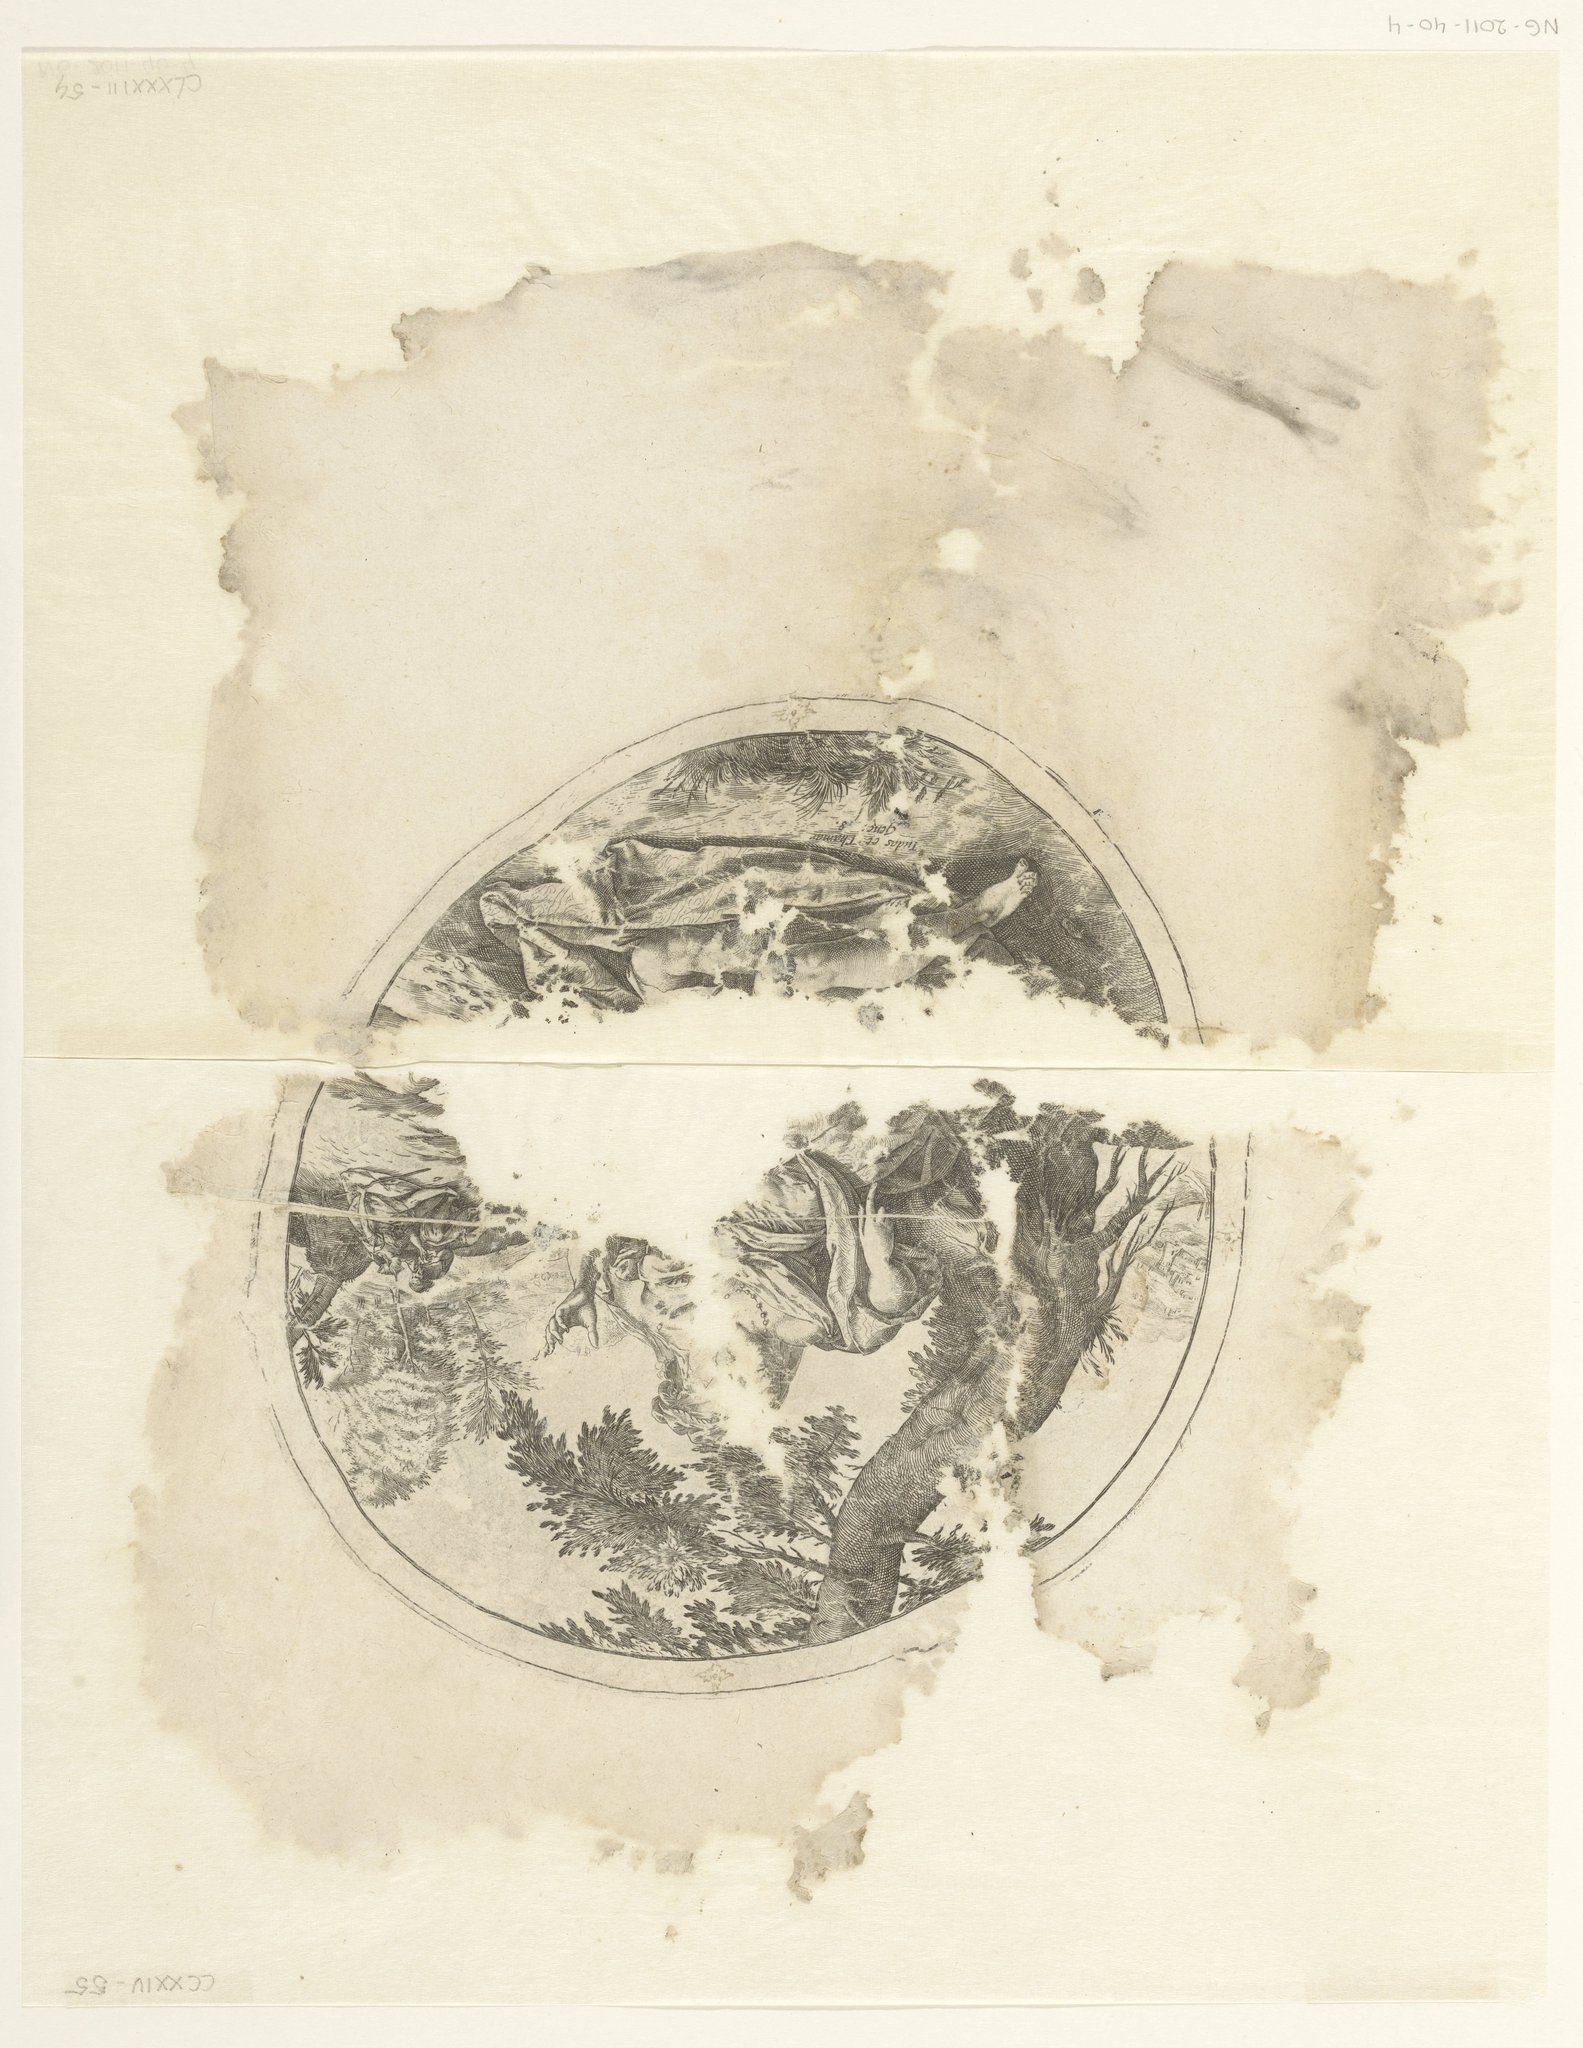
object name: print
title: Juda en Tamar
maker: hendrick goltzius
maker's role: draughtsman, painter, print maker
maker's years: 1558-1617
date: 1580-1596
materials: paper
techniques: engraving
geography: haarlem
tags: story of judah and tamar (genesis 38), tamar changes from her widow's clothes and covers her face with a veil after the manner of the prostitutes; sitting at the entrance of a city on the road to timnath she awaits judah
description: Toeschrijving aan Goltzius door Weigel, verworpen door Hirschmann (en zo ook in TIB en Hol). New Hollstein Dutch beschrijft de prent bij de 'doubtfull attributions'. De prenten in de Nova Zembla collectie zijn tijdens een expeditie van Willem Barendsz en Jacob van Heemskerk in 1596-1597 noodgedwongen in het winterkamp, het ‘Behouden Huis’, op het eiland achtergelaten. De prenten waren in één of meerdere stapels als handelswaar meegenomen vanuit Amsterdam. Bijna drie eeuwen later, in 1871, keerde de Noor Elling Carlsen terug naar Nova Zembla en vond daar de restanten van het ‘Behouden Huis, inclusief een groot deel van de inventaris. Een deel van de prenten, in de vorm van aaneengekoekte kluiten, werd toen ook teruggevonden. De papierkluiten waren soms op meerdere plekken gebroken. Tussen 1975-1979 zijn de prenten van elkaar gescheiden. Dit leverde in totaal ca. 1000 fragmenten van ca. 400 afdrukken van ca. 150 verschillende prenten op. Voor zover mogelijk zijn de fragmenten samengevoegd en zijn de prenten gereconstrueerd.